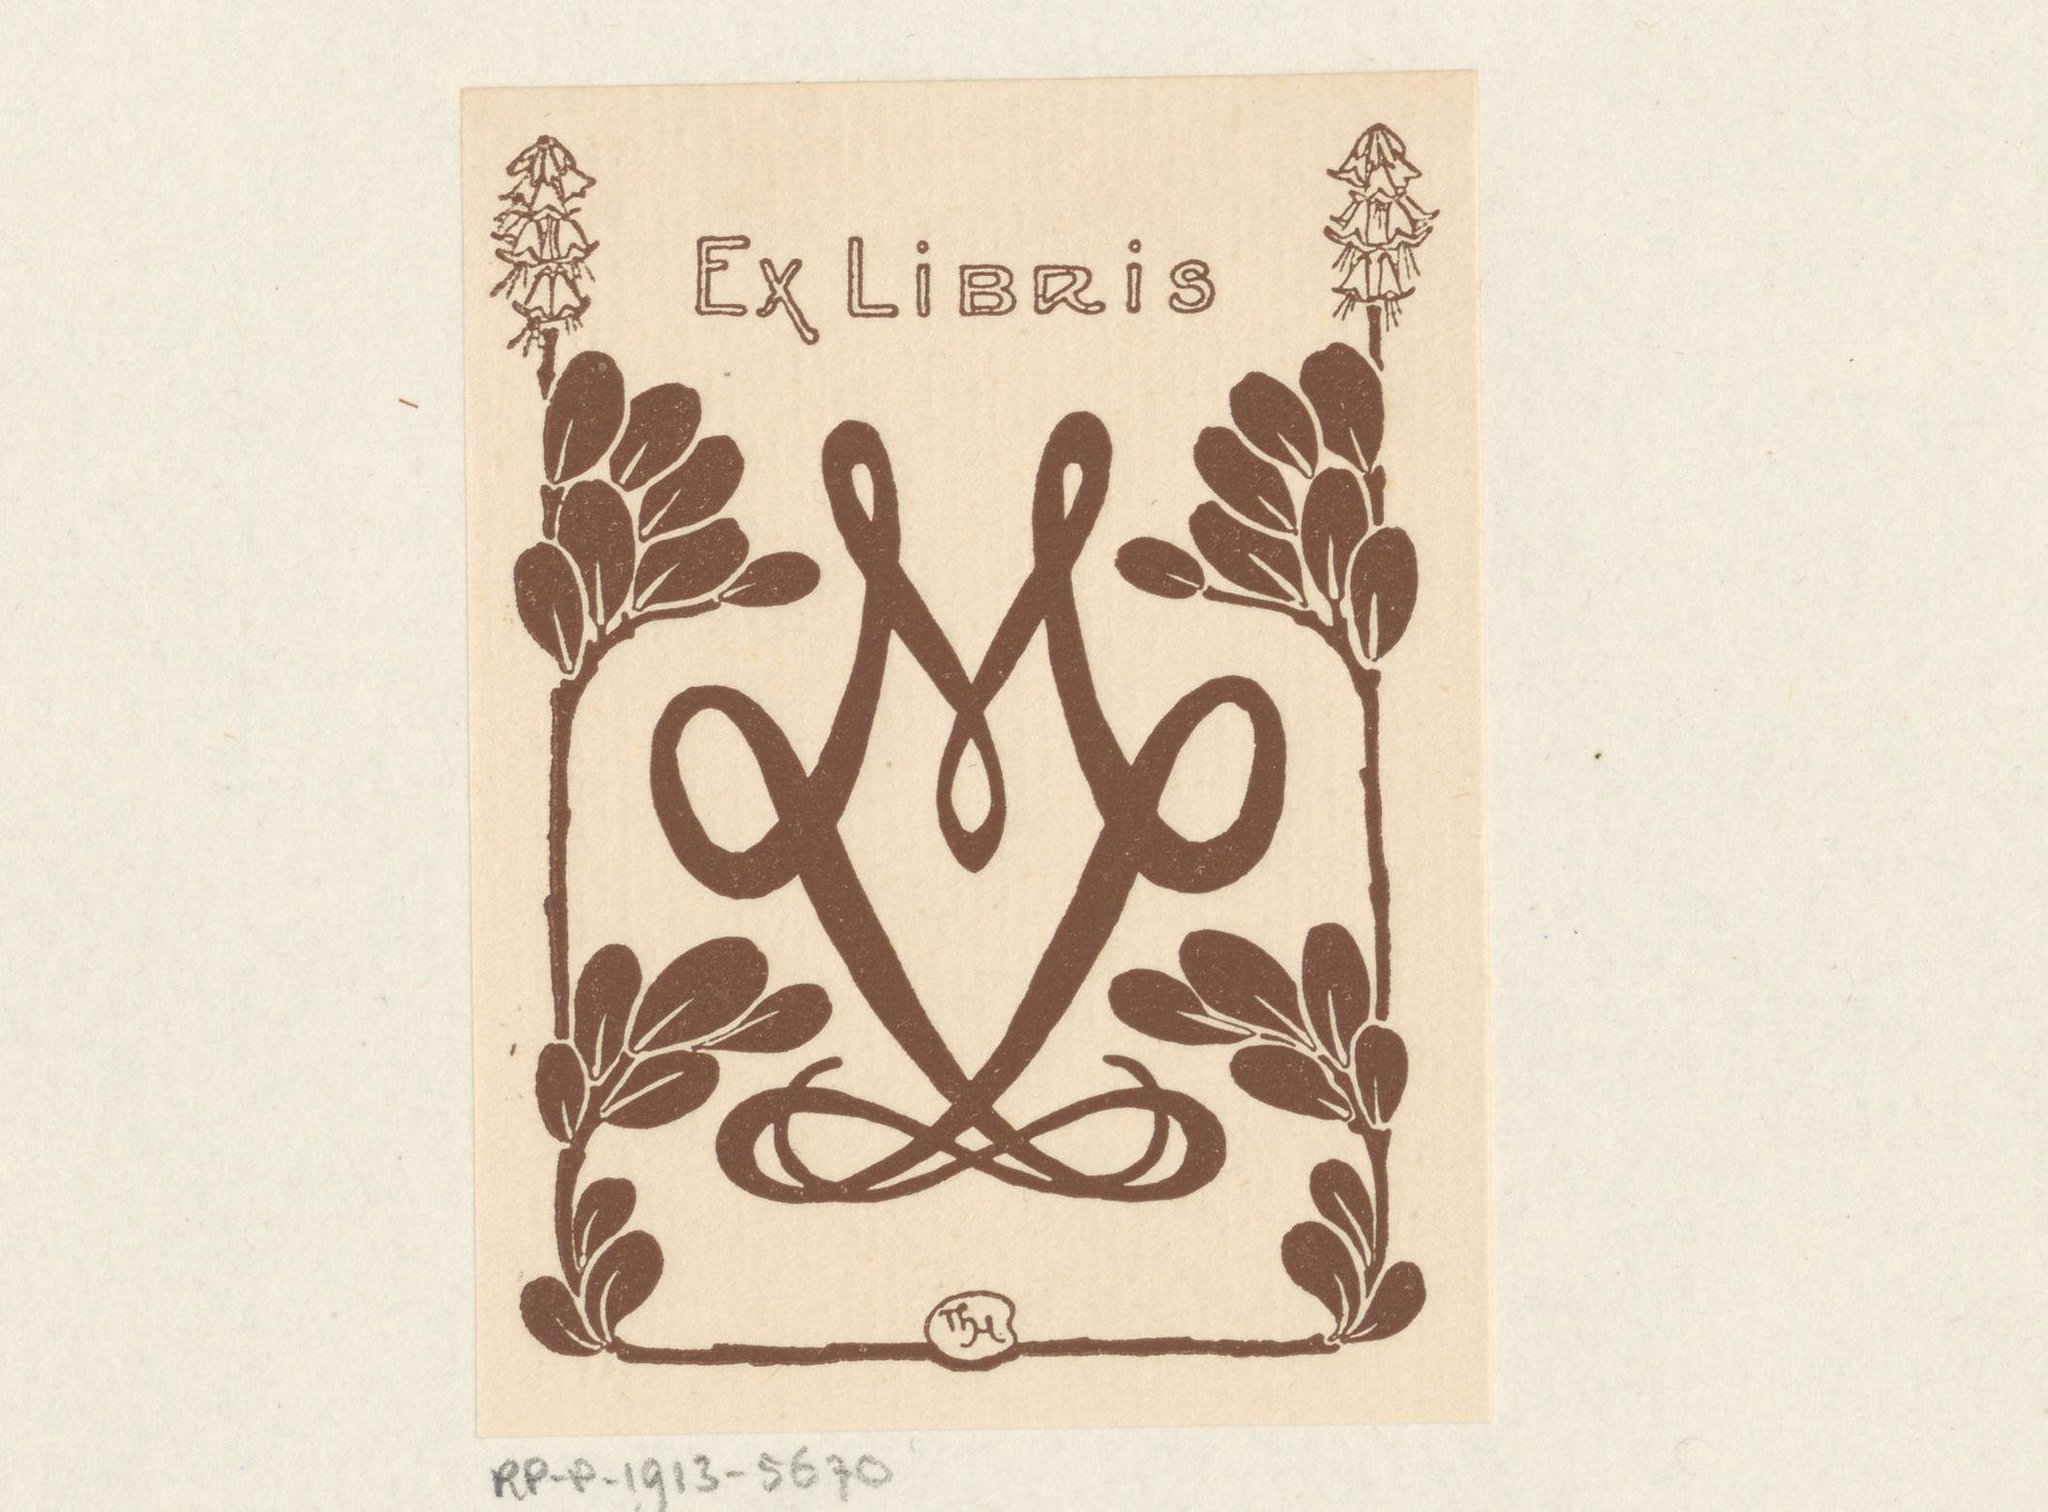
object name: bookplate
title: Ex libris van M.L.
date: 1906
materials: paper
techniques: printing block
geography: norway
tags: flowers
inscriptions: collector's mark: Lugt 2233, collector's mark: Lugt 2760, inscription: ‘M. Lyng / Kristiania’